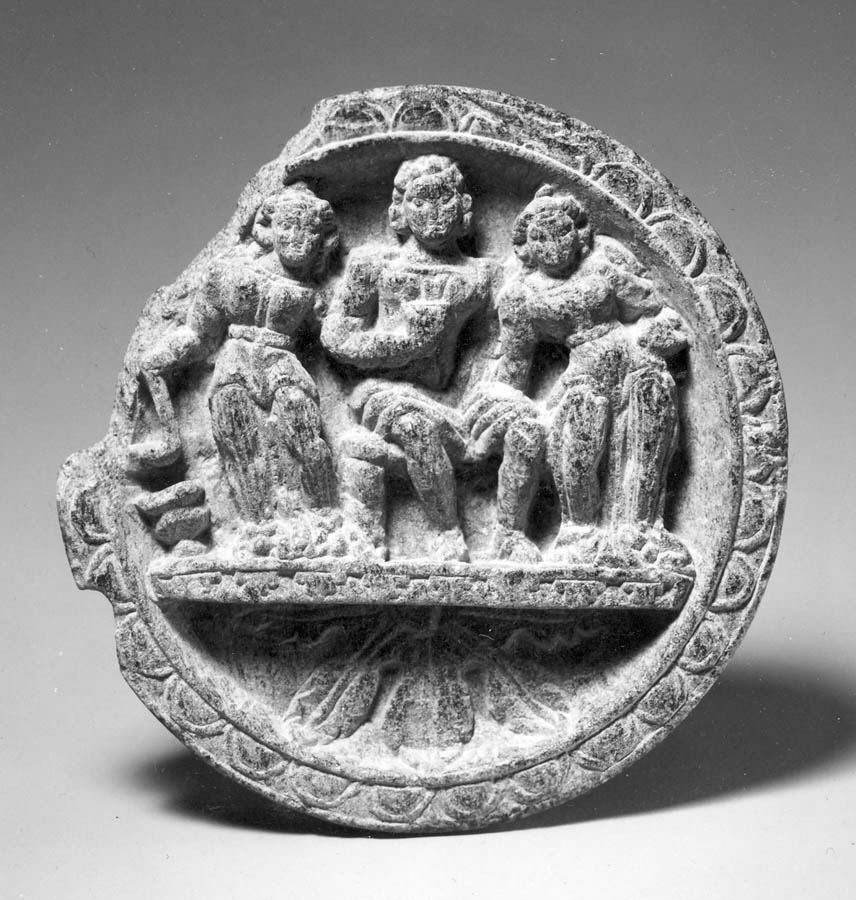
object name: dish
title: Dish in Two Sections with Three Figures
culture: gandhara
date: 1-100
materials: stone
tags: human figures,gandhara